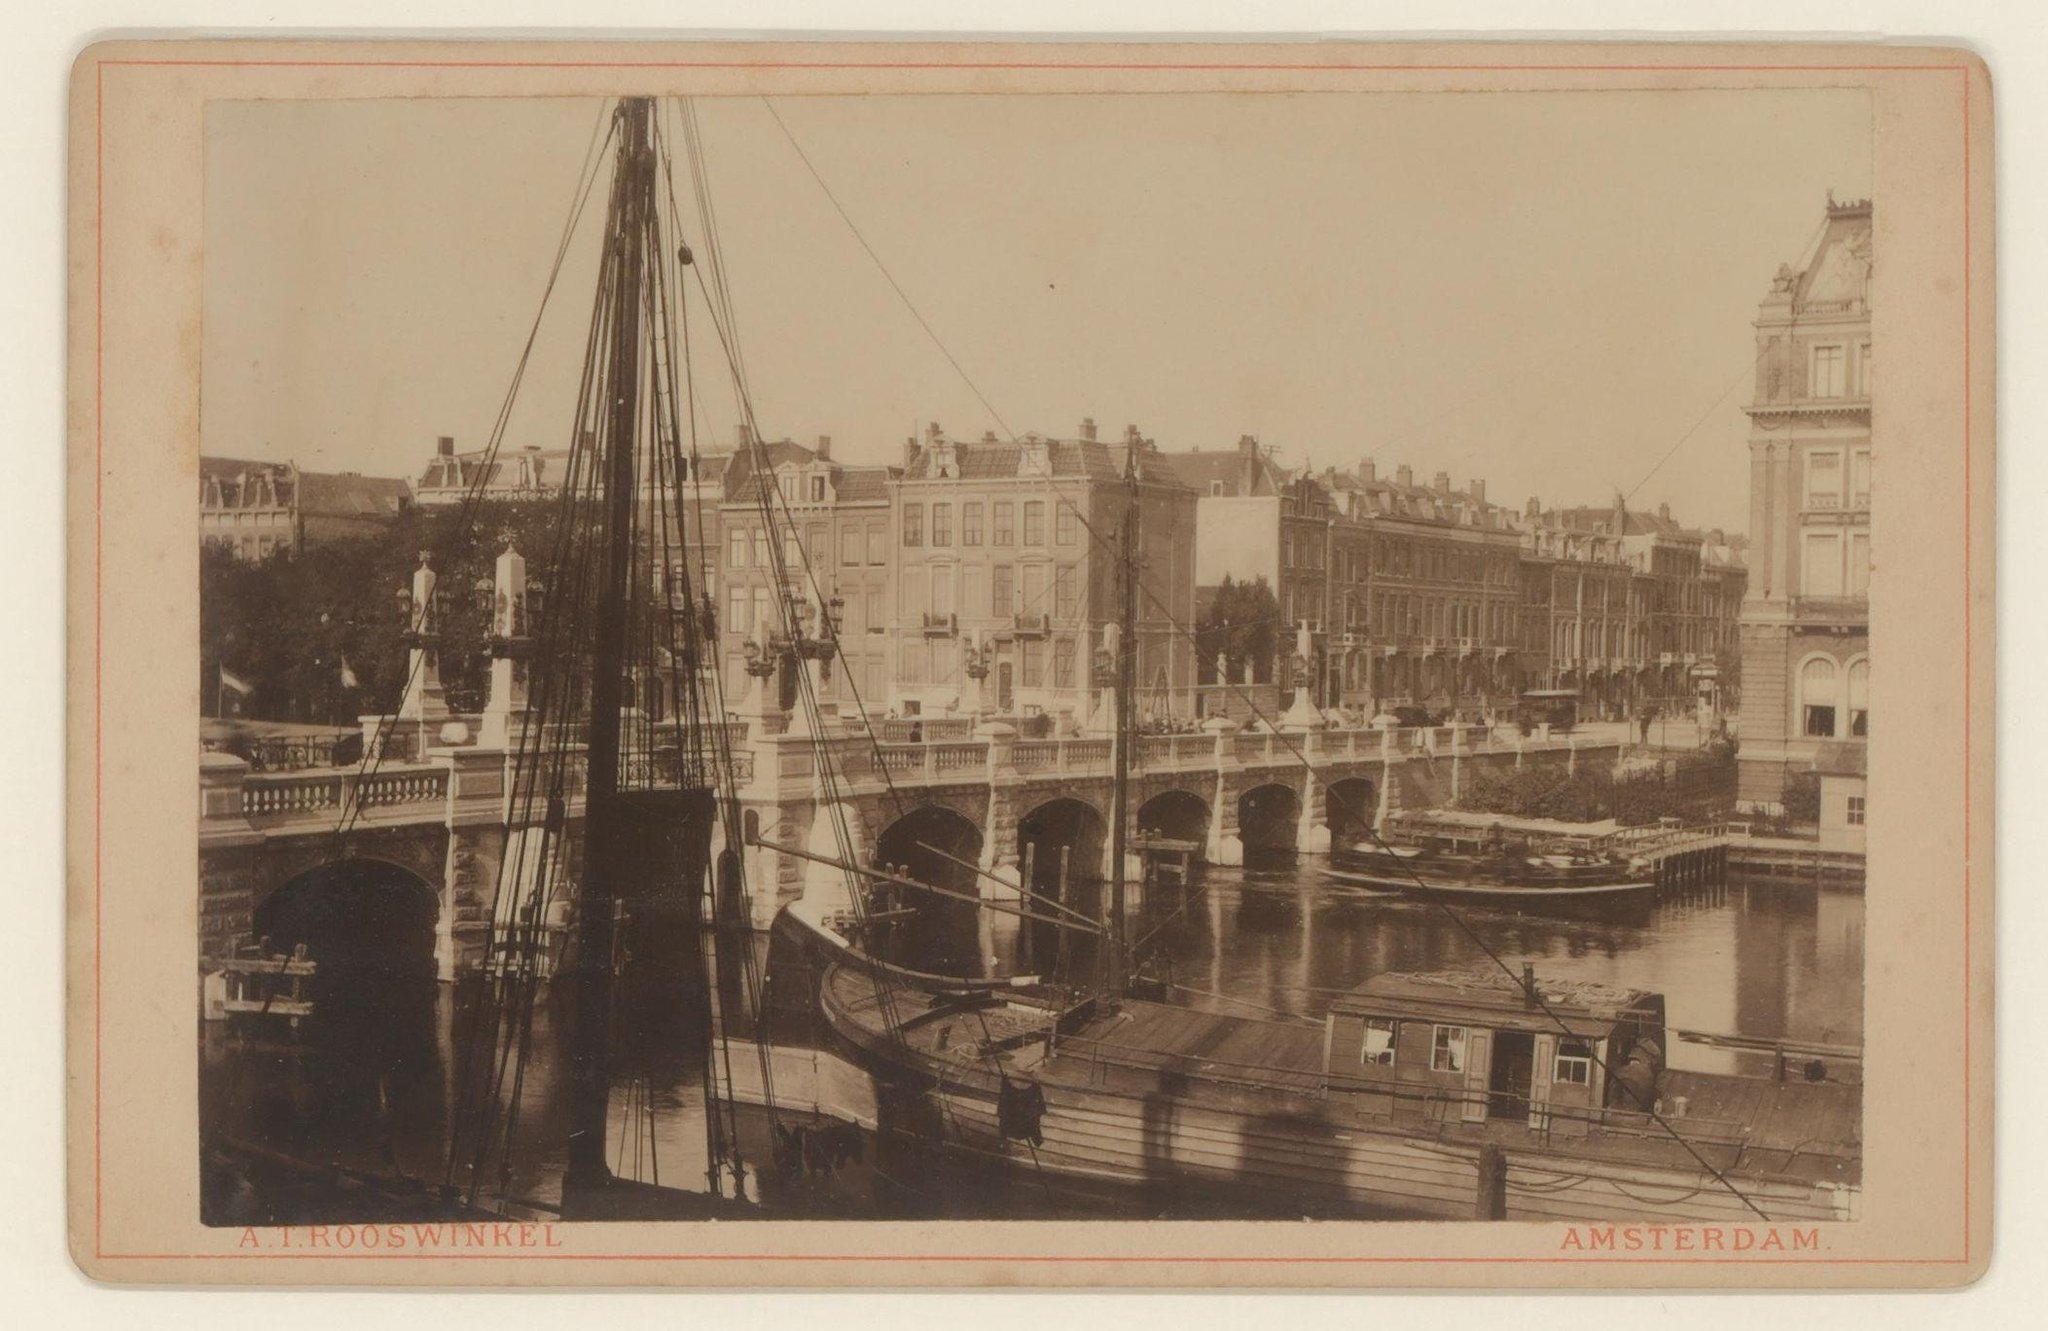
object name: cabinet photograph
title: Gezicht op de Hogesluis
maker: andreas theodorus rooswinkel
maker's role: fotograaf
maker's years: 1838-1909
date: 1875-1896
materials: paper, cardboard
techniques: collodion silver print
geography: amsterdam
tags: city-view in general; 'veduta', canal, bridge in city across river, canal, etc.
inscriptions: stamp: ‘Gebr. Douwes / Atelier Grimburgwal 15 / Amsterdam.’, collector's mark: ‘4’ Lugt 1641b, inscription: ‘Hooge School. Sluis.’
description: Onderwerpsrubriek binnen de Atlas Amsterdam: Amstel van Blauwbrug tot Hogesluis.